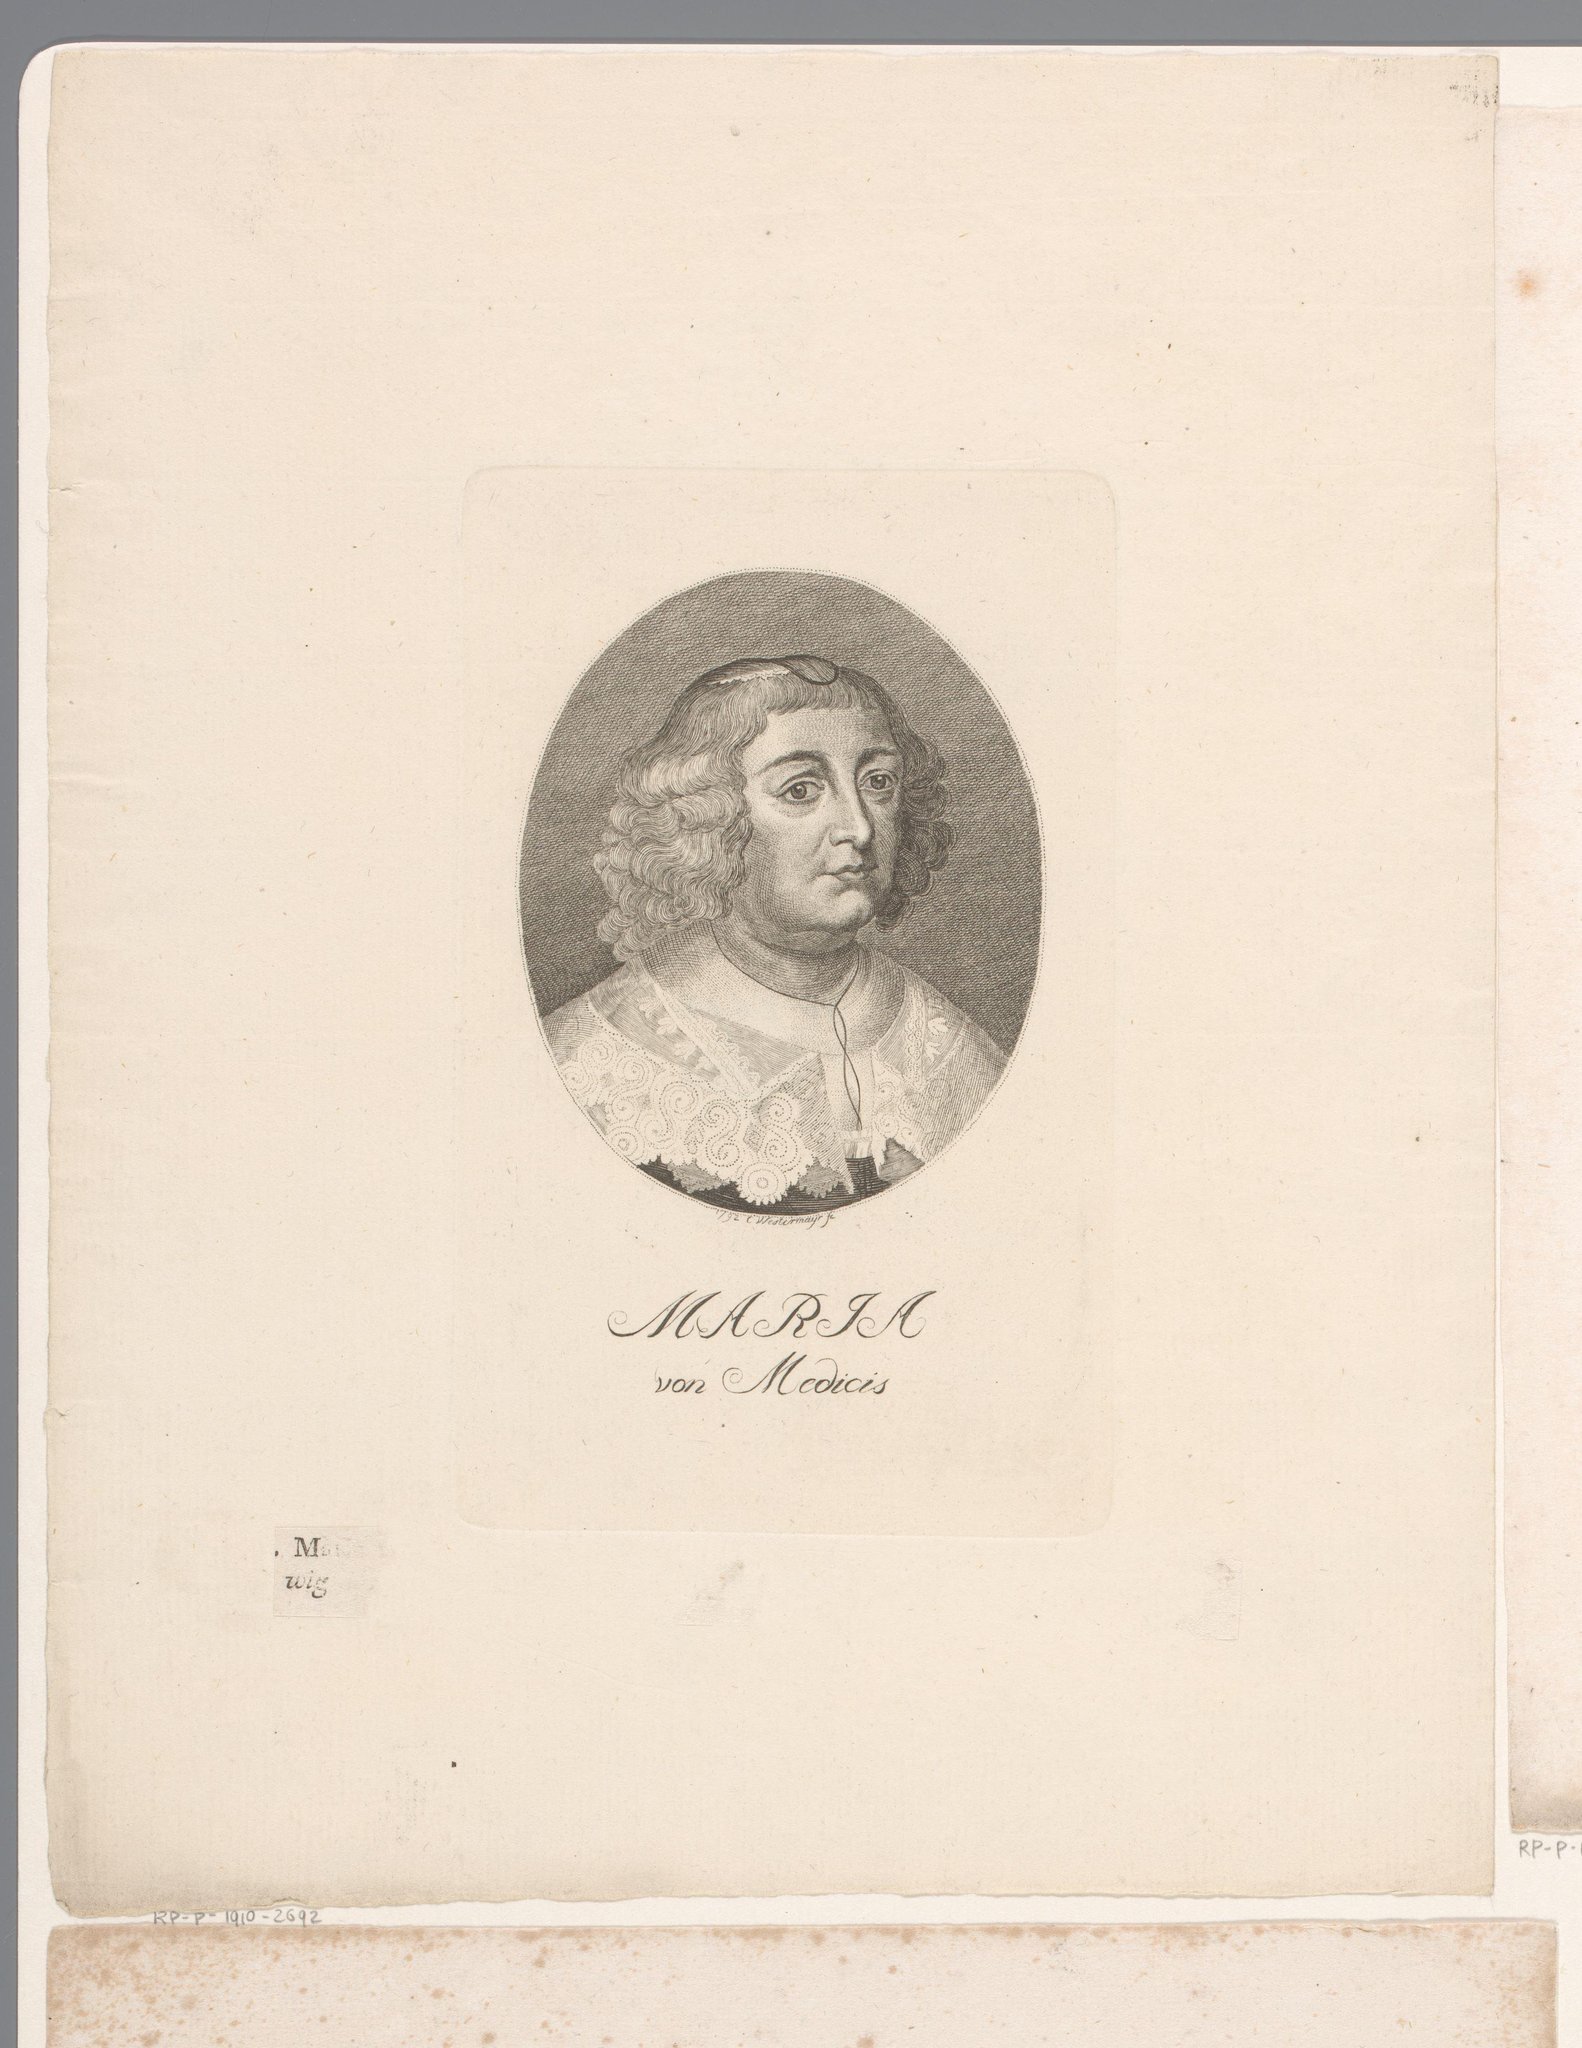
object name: print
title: Portret van Maria de' Medici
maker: konrad westermayr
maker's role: print maker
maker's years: 1765-1834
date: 1792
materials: paper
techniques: engraving, etching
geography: germany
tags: maria de' medici, historical persons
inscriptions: collector's mark: Lugt 2228